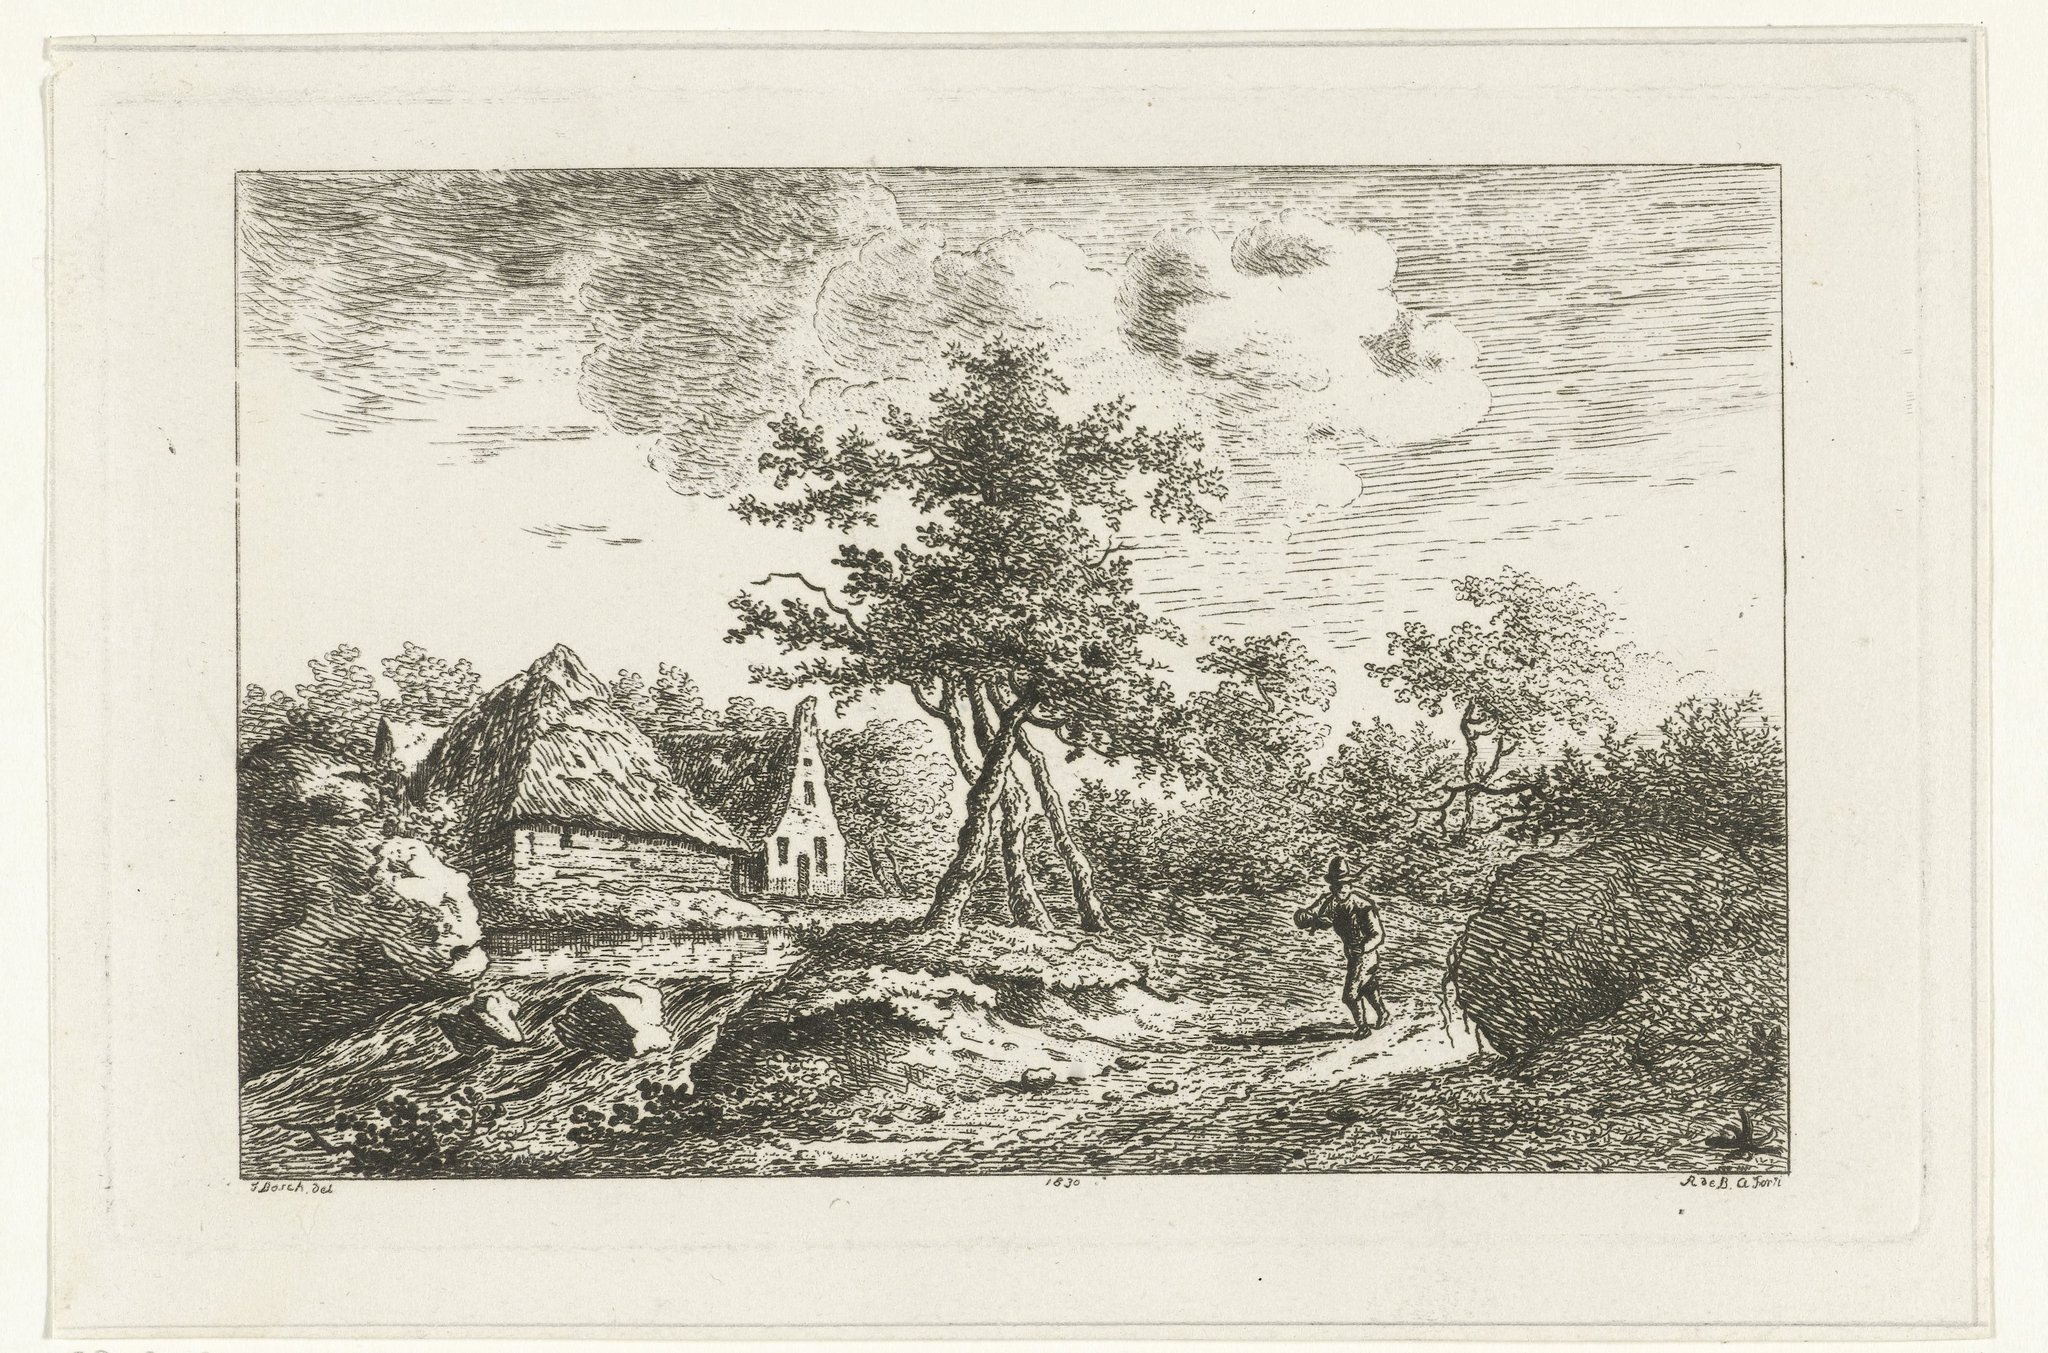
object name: print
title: Landschap met boerderij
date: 1830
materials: paper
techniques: etching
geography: vaassen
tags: farm or solitary house in landscape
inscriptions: collector's mark: Lugt 2228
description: Een landschap met links een boerderij, in het midden drie bomen en rechts een wandelaar.